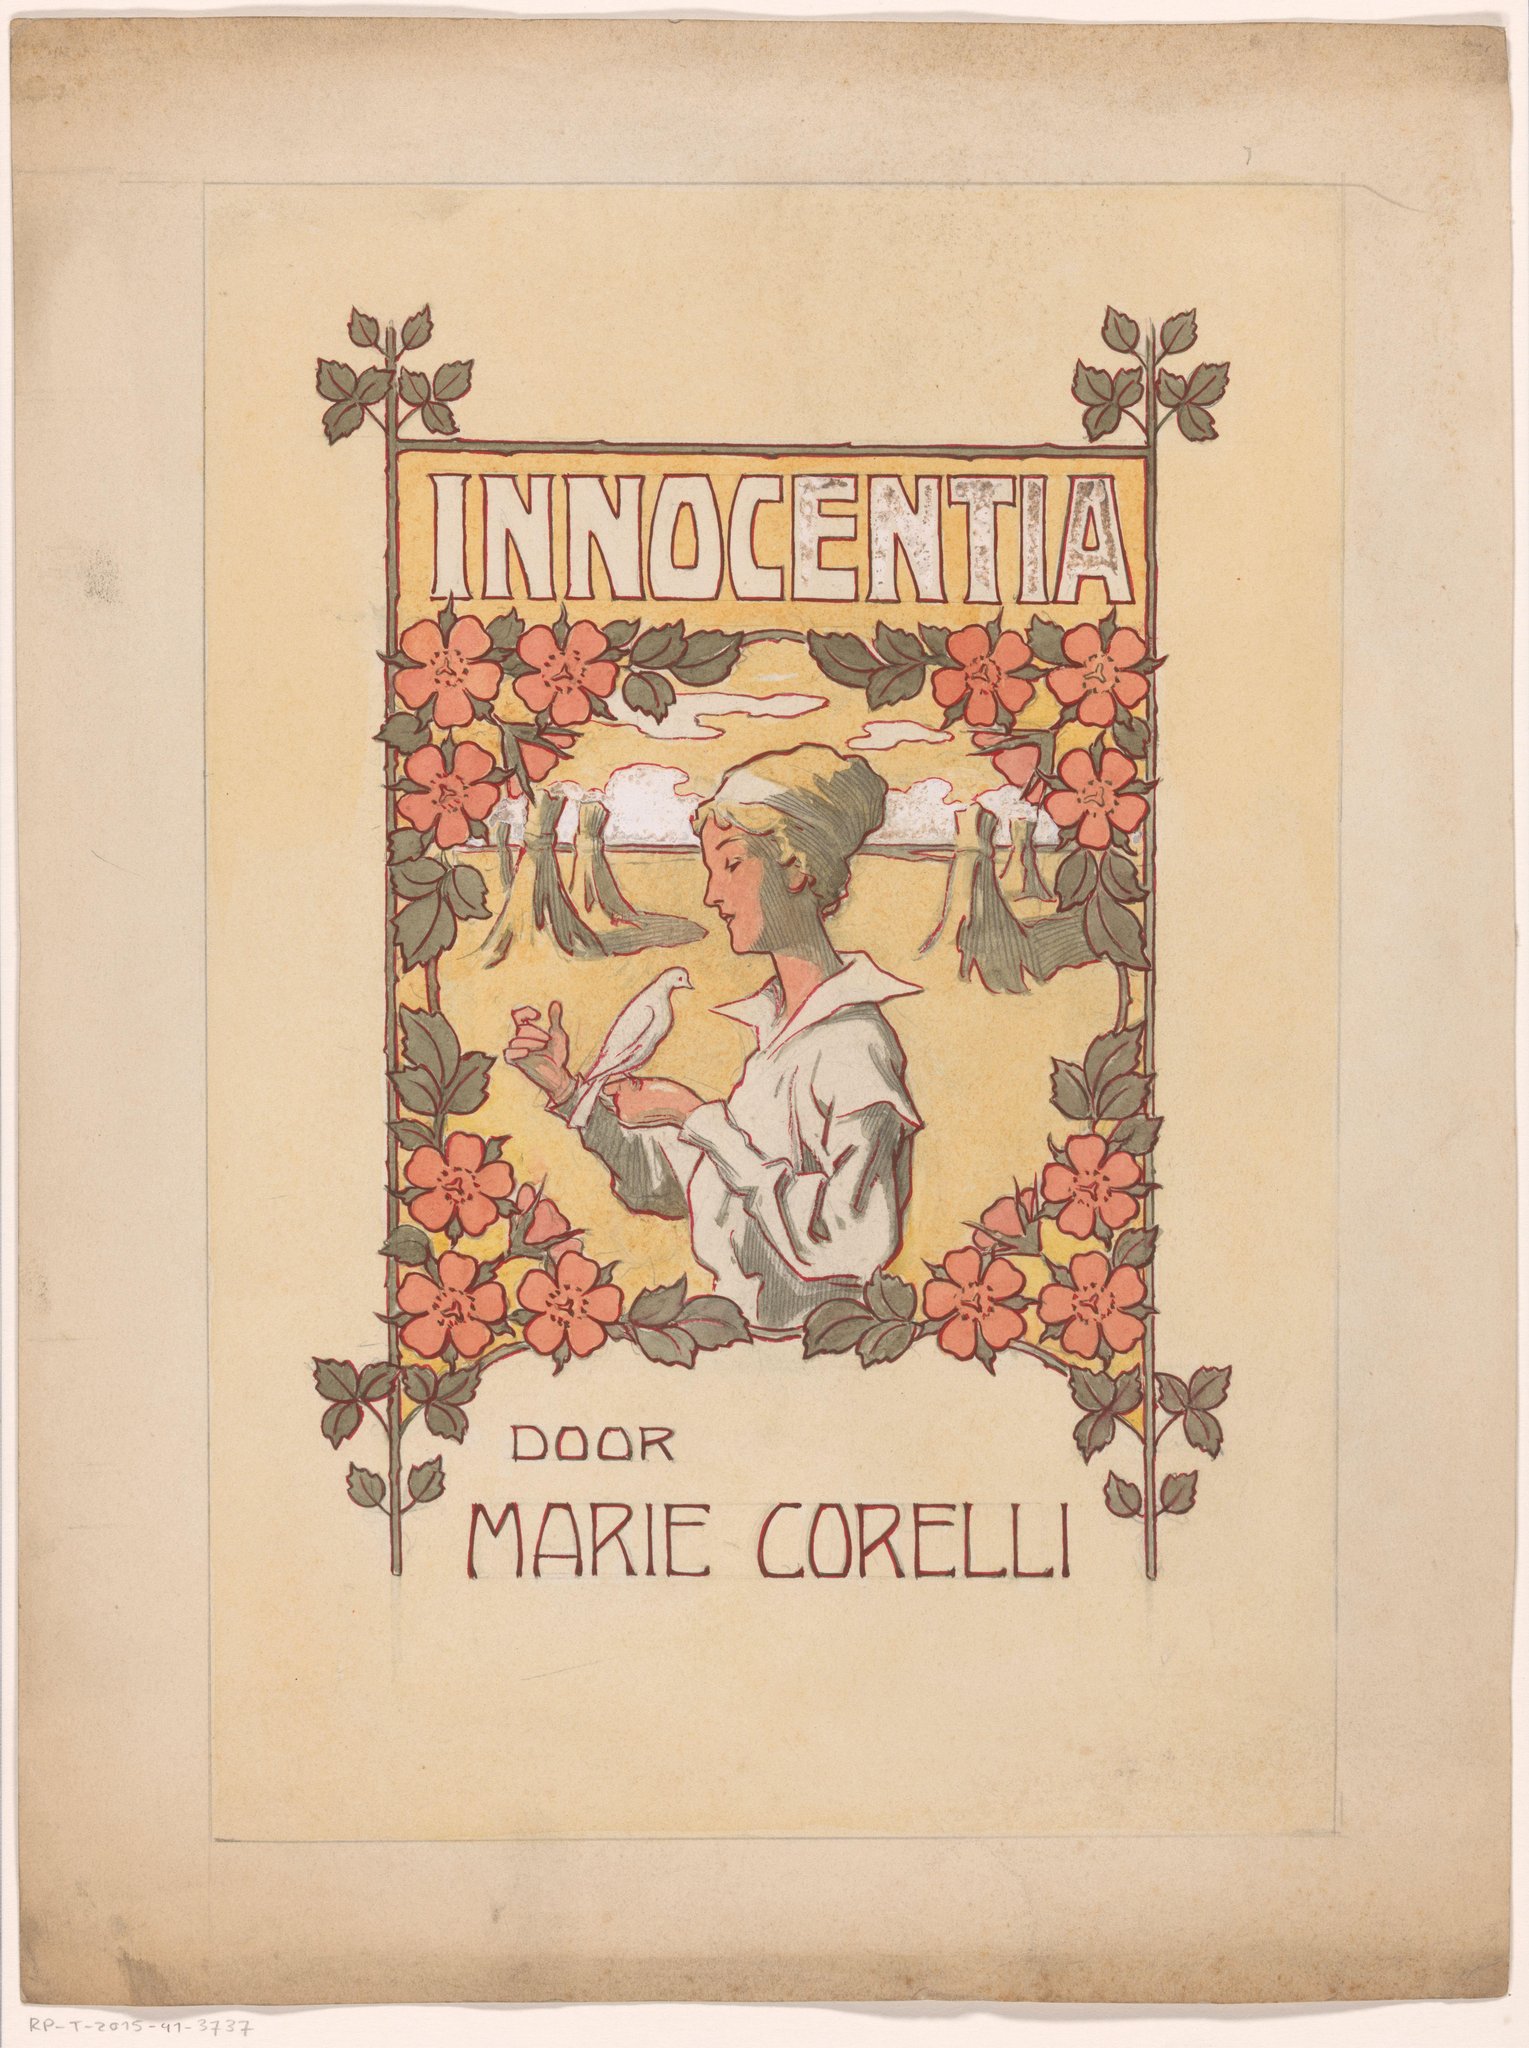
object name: study for binding design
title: Bandontwerp voor: Marie Corelli, Innocentia: droomleven en werkelijkheid (Innocence), 1915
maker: Anonymous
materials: paint, ink, paper, pencil, watercolor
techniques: brush, pen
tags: flowers, other birds: dove, ear of corn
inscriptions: collector's mark: Lugt 2228a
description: Een vrouw staat in een landschap met korenschoven met een witte duif op haar hand. De voorstelling is omgeven door een bloemenkrans.